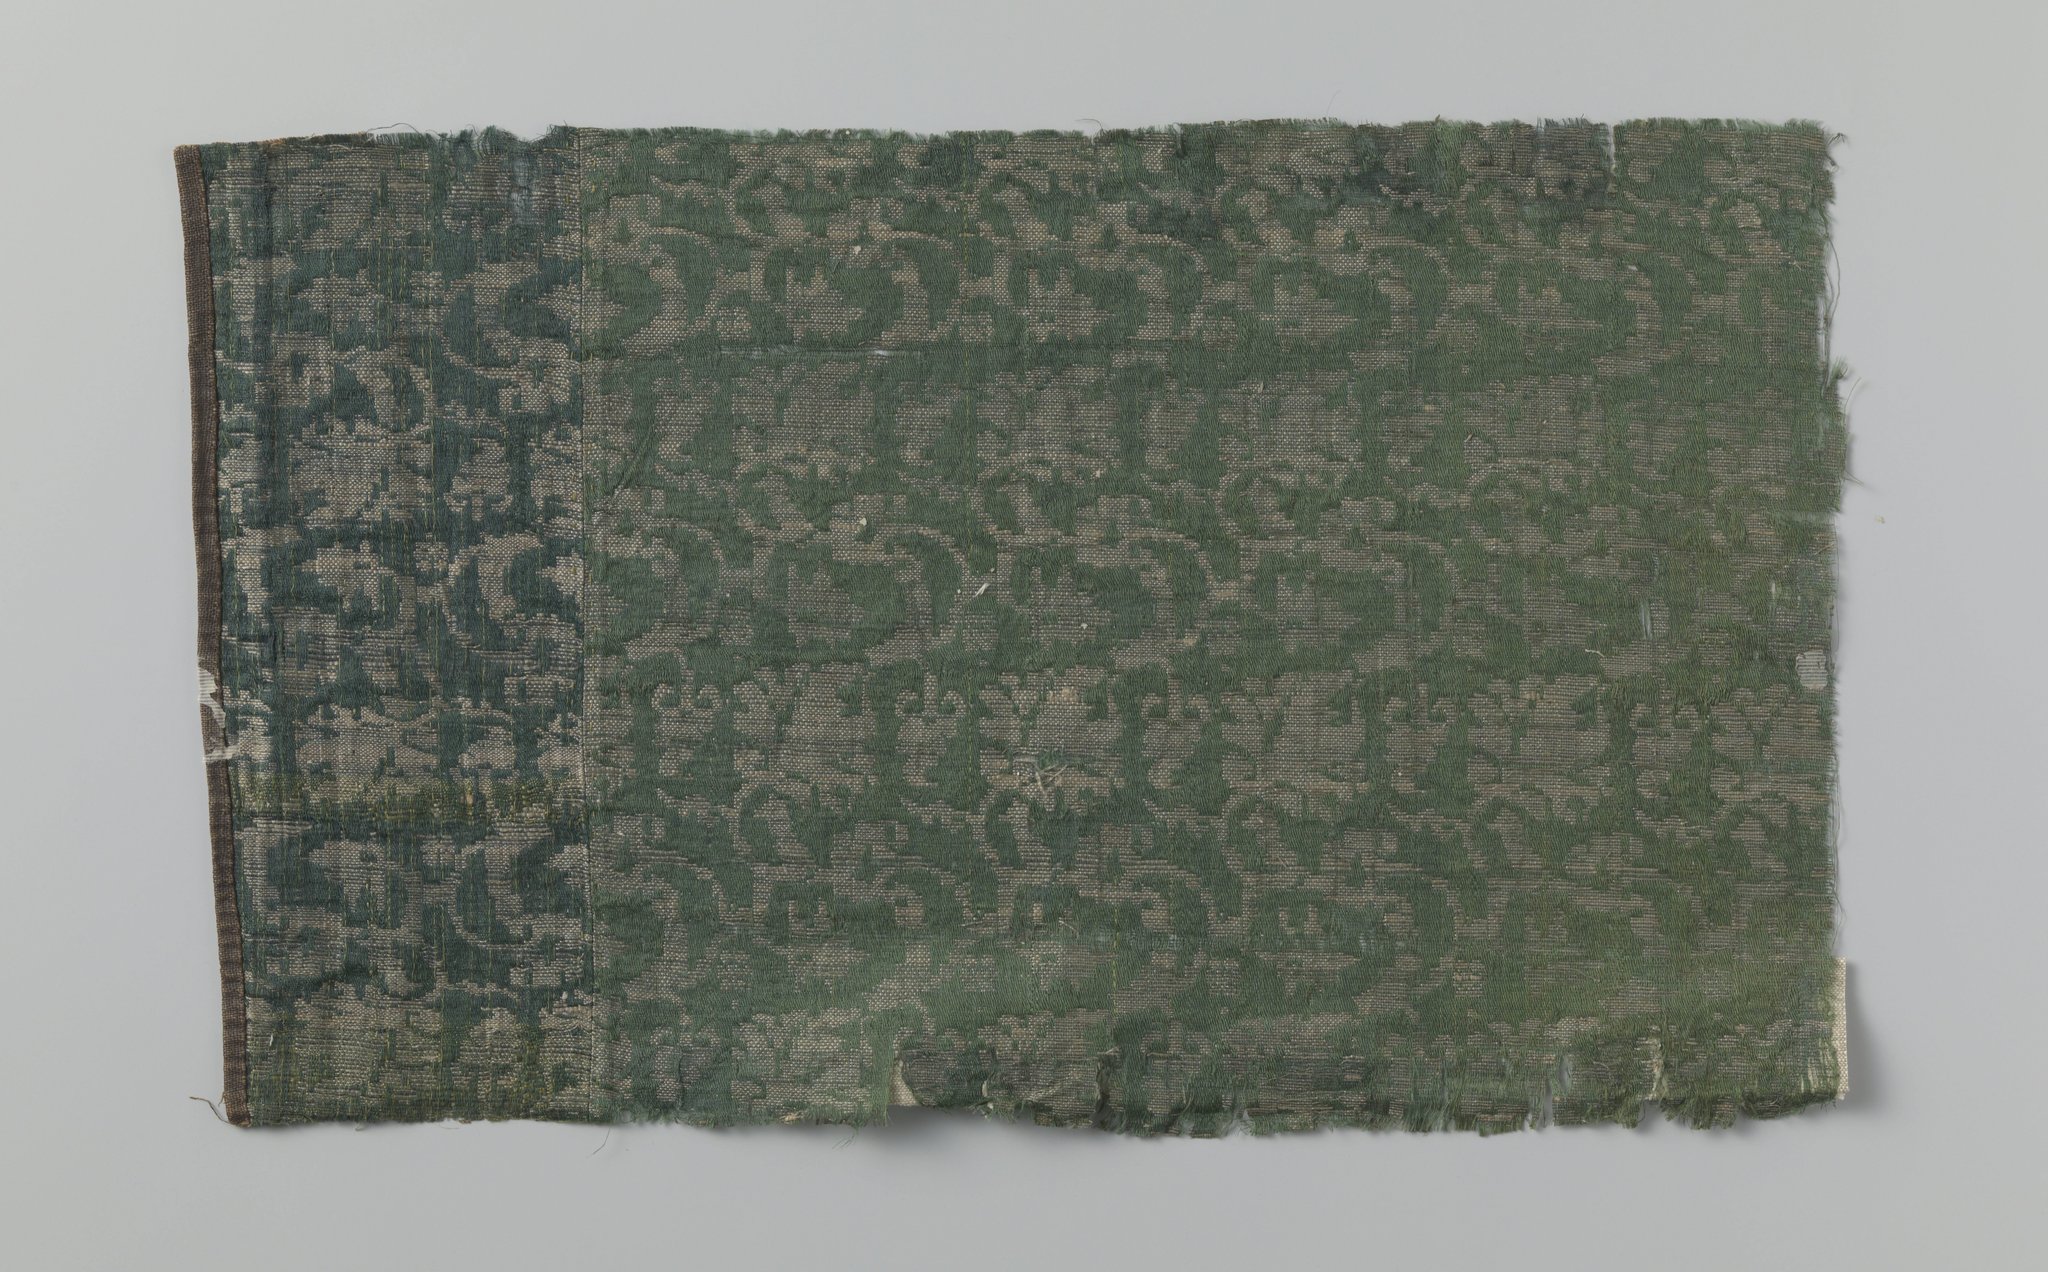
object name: fragment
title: Fragment zijdeweefsel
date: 1300-1399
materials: linen, silk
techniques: liseré, satin binding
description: Fragment van groene zijde met patroon van horizontaal gerijde gstyleerde wingerdbladeren aan gebogen stelen. Deels verstevigd met bruin linnen. Zelfkant is groen met witte rand.